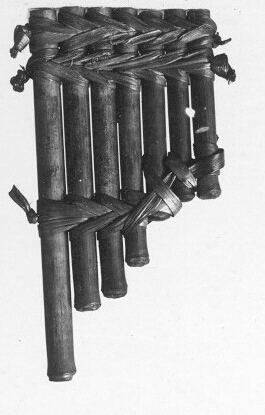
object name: bue balabala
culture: melanesian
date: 1867-1900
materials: bamboo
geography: vanuatu